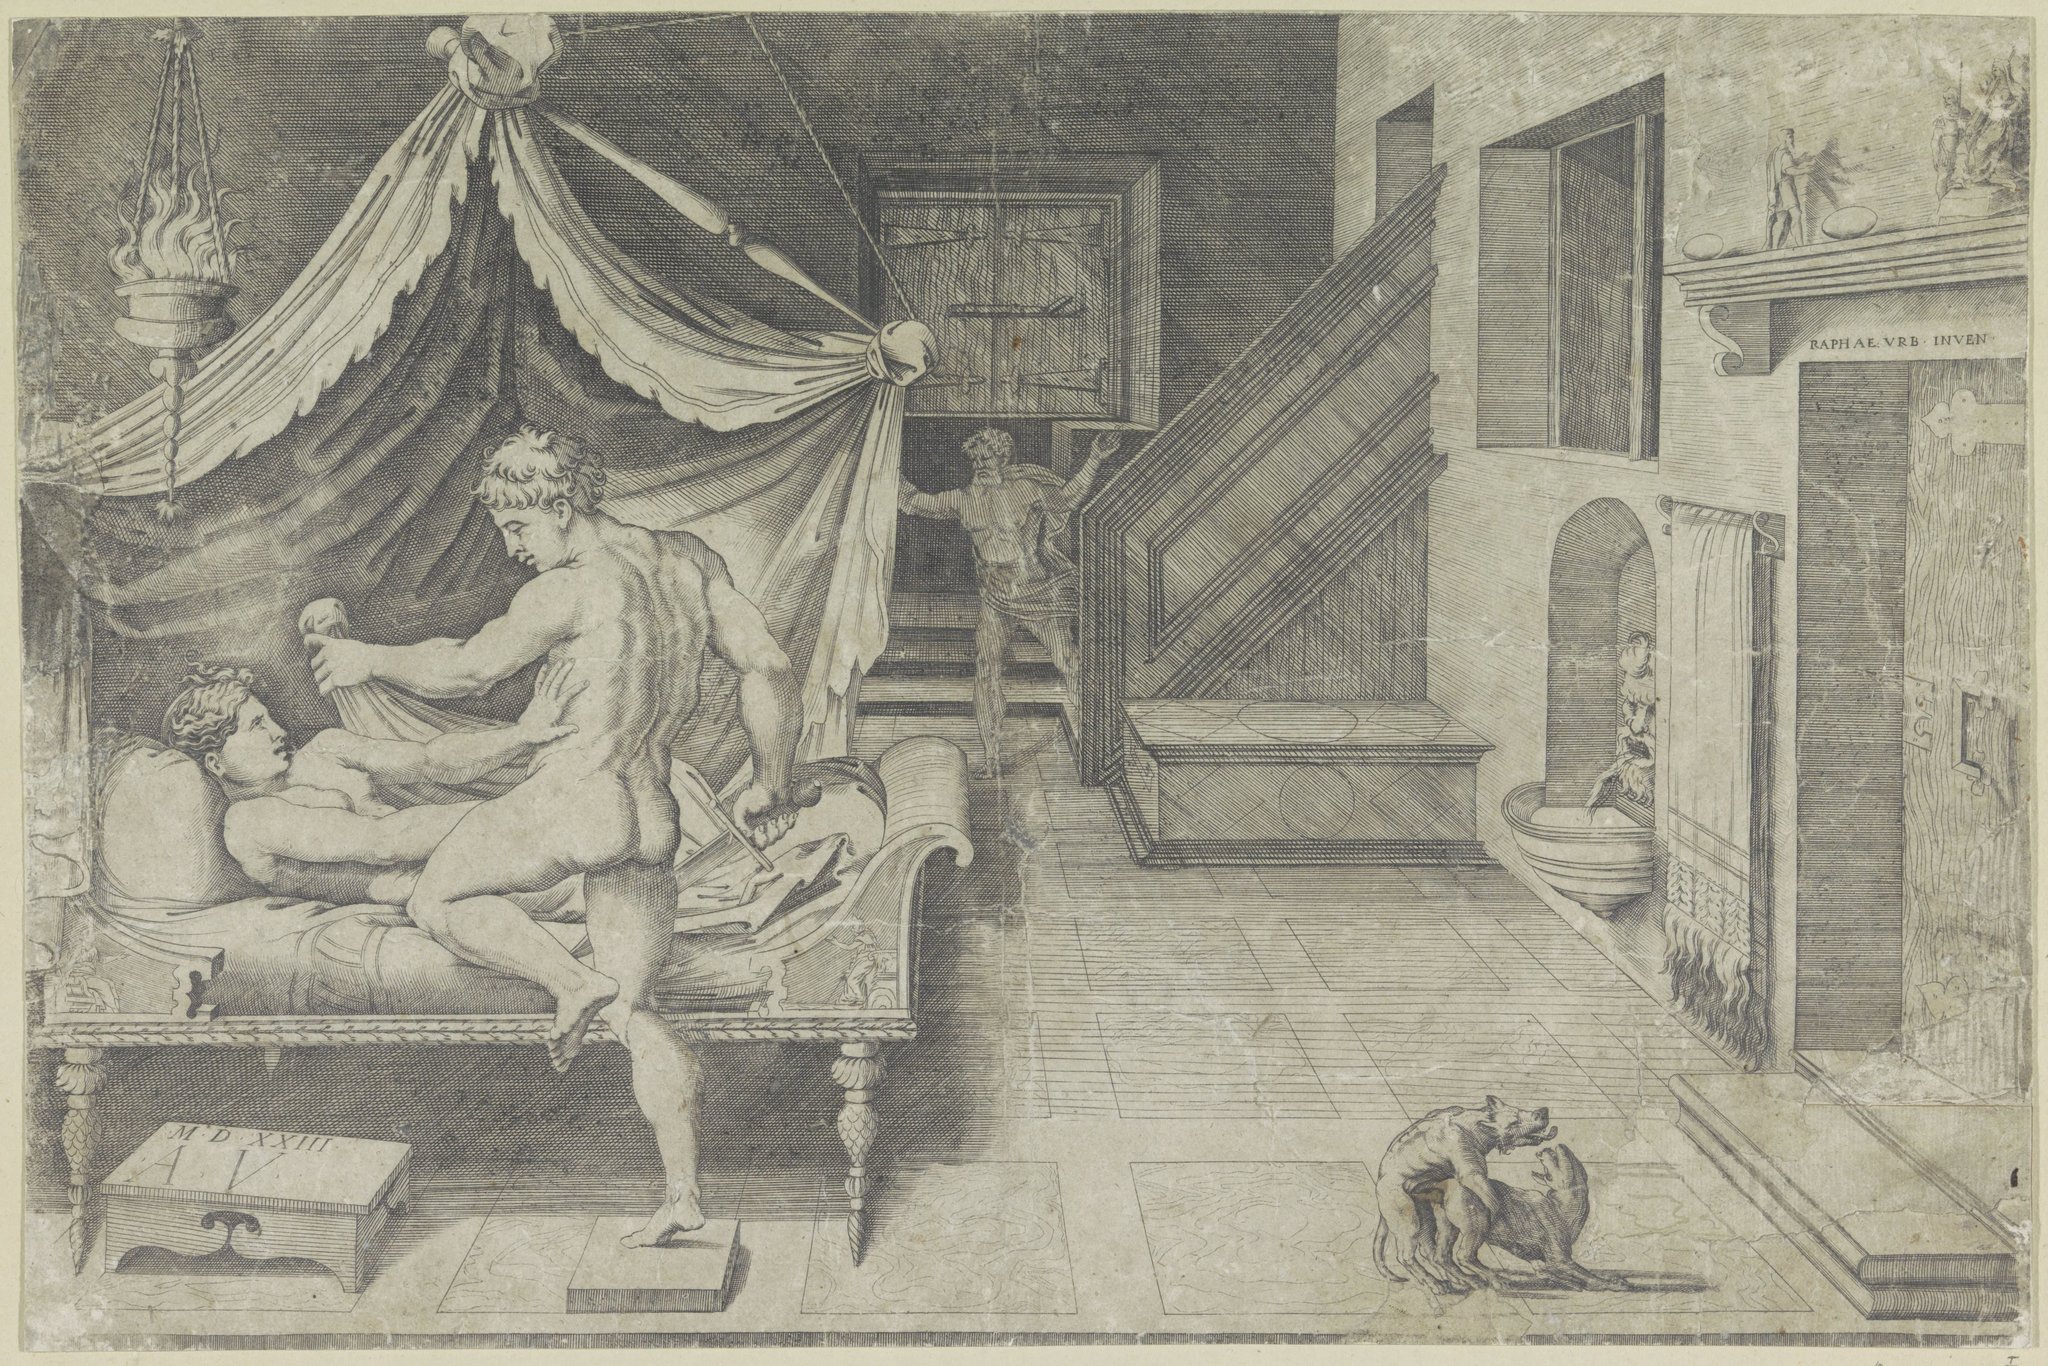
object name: print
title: Verkrachting van Lucretia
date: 1523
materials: ink, paper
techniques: engraving, pen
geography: italy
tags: the rape of lucretia: sextus tarquin threatens her with a dagger or a sword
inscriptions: collector's mark: Lugt 11, collector's mark: Lugt 10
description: Lucretia, naakt in haar bed, probeert de aanvallende Sextus Tarquinius met zwaard van zich af te weren. Achterin komt een man de kamer binnen. Rechts in de voorgrond twee parende honden.